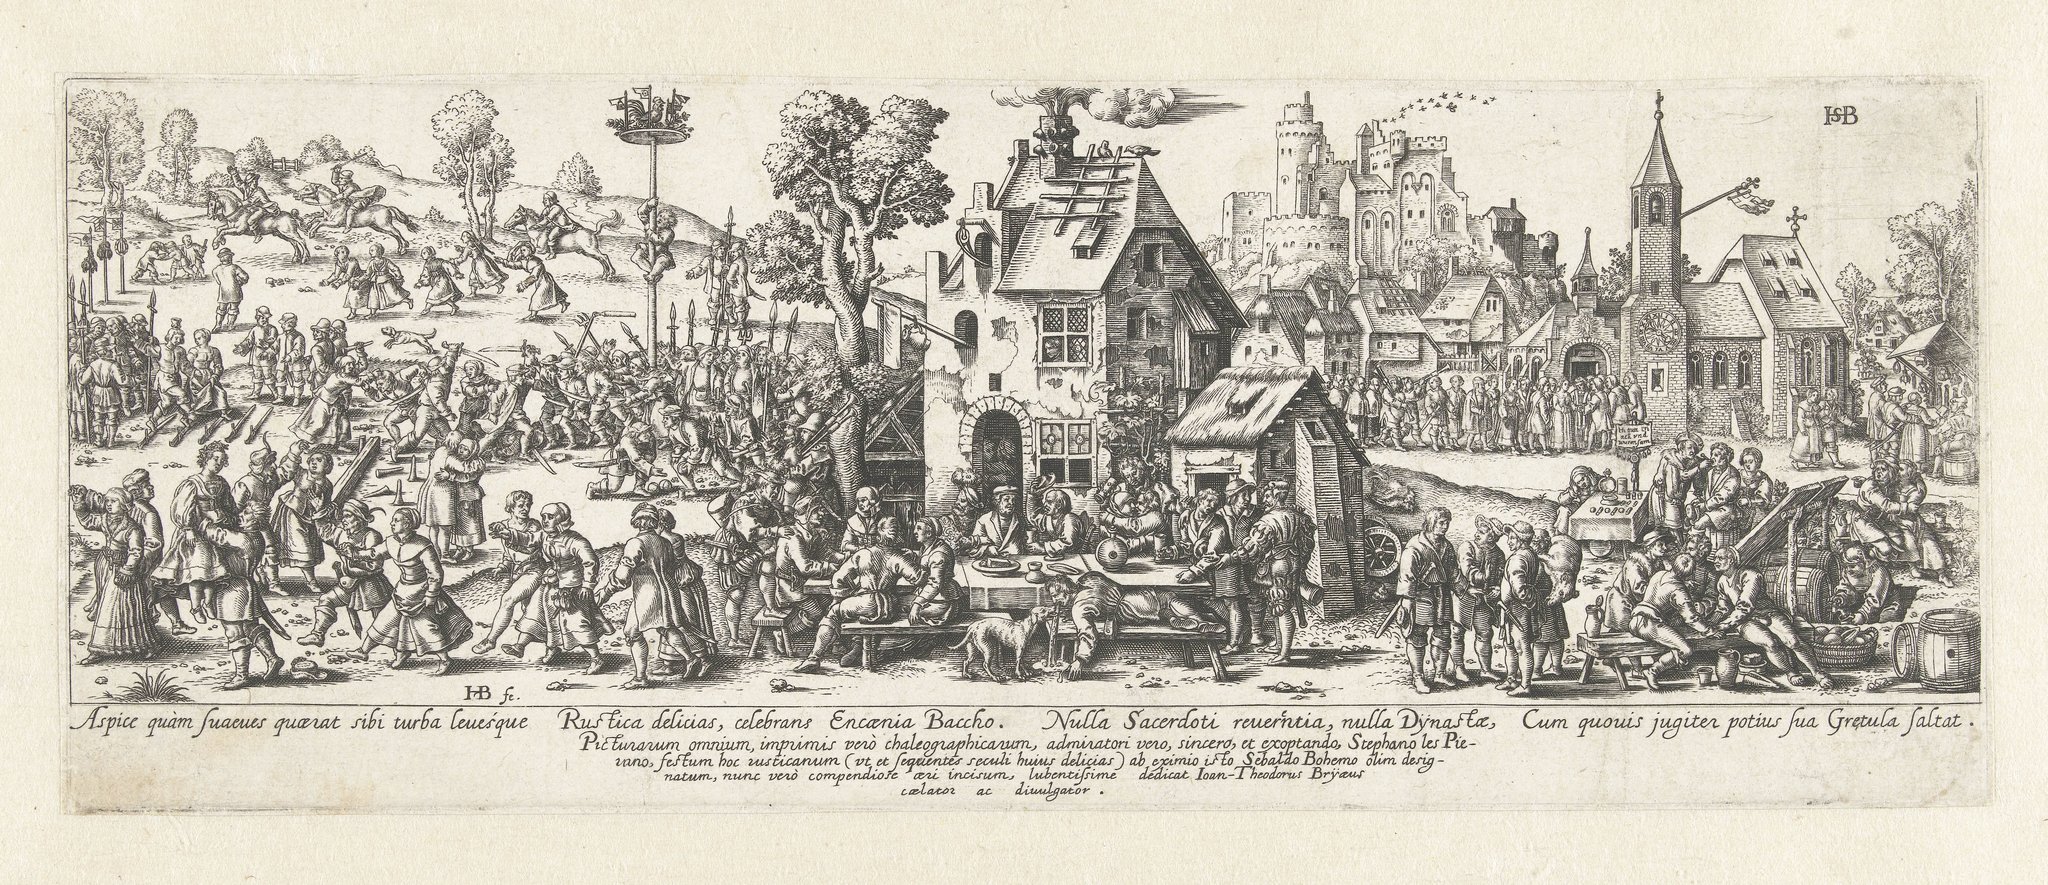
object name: print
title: Dorpskermis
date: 1588-1623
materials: paper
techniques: engraving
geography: germany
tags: carousal, drinking-bout, orgy, inn, coffee-house, public house, etc., pleasure fair and circus, couple entering the church ~ marriage, quack extracting teeth or molars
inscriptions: collector's mark: Lugt 240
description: In het midden voor een herberg een drinkend en feestend gezelschap. Links wordt gedanst en gevochten en worden verschillende spelen gedaan. Rechts drinkende boeren bij een wijnvat en een kiezentrekker. Op de achtergrond een kerk waarvoor een huwelijksplechtigheid. Geheel achter een burcht. Met onderschrift in het Latijn.